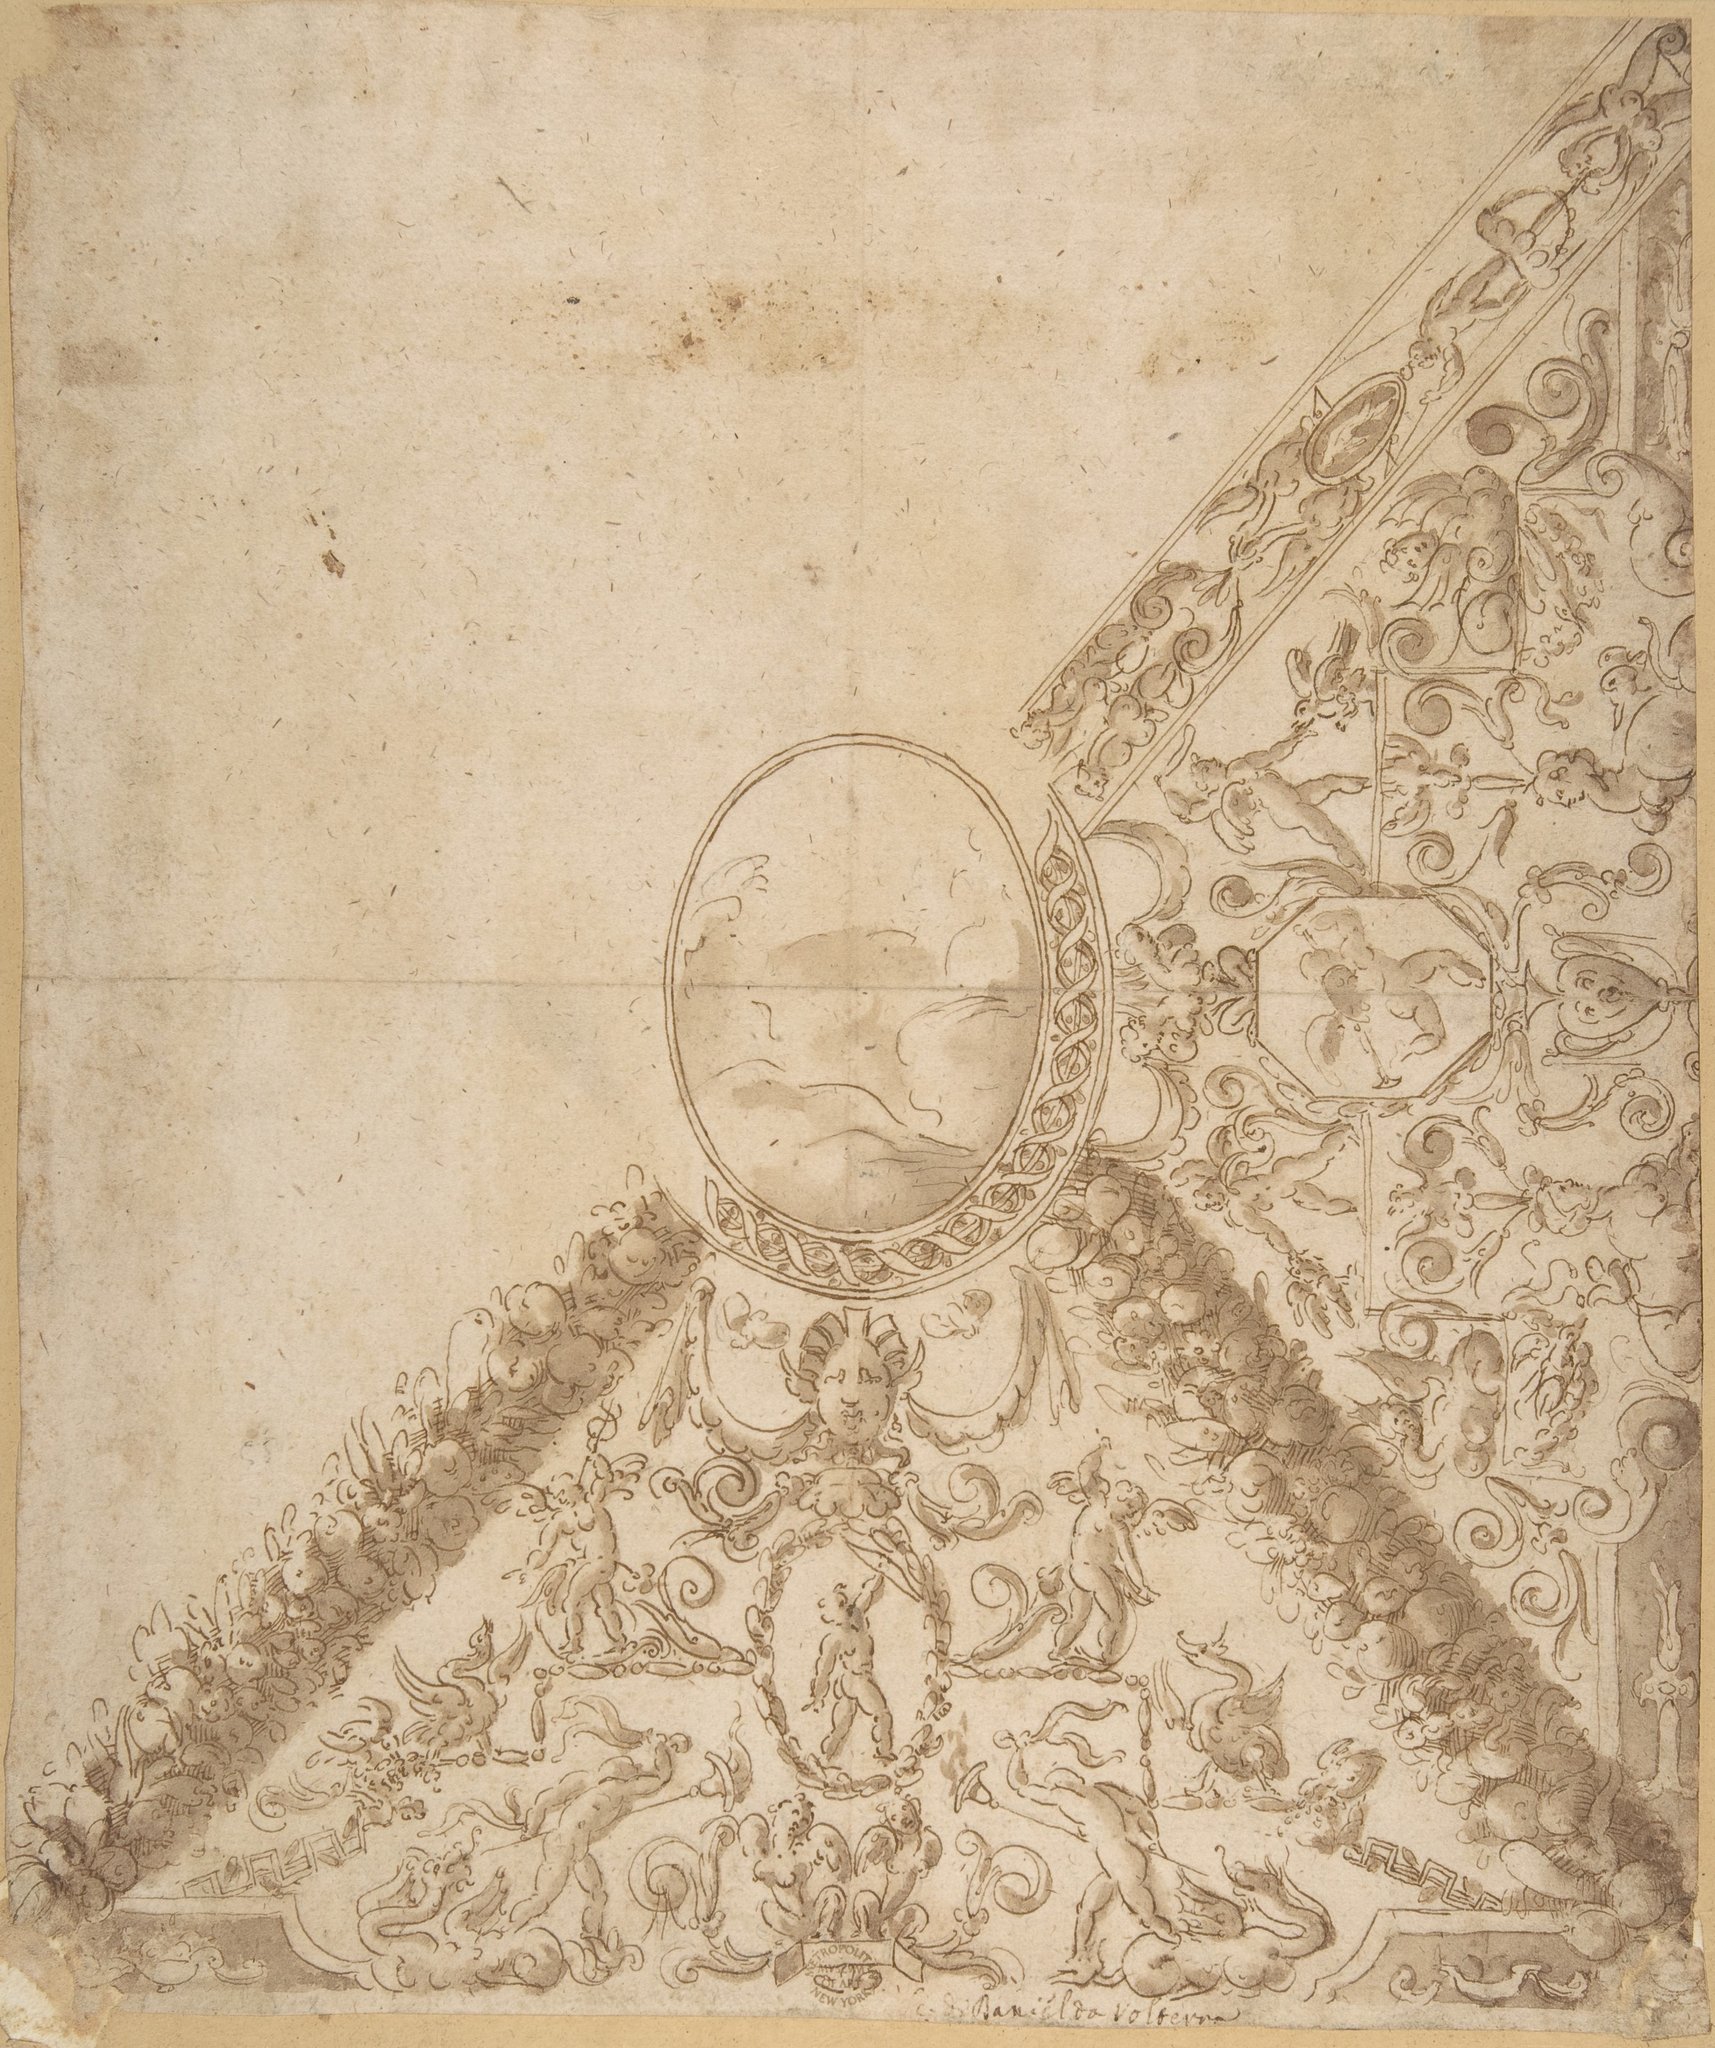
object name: drawing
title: Sketch for Ceiling Decoration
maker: anonymous, italian, 16th century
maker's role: artist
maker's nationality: italian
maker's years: 1550-1600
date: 1501-1600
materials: ink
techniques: pen, wash